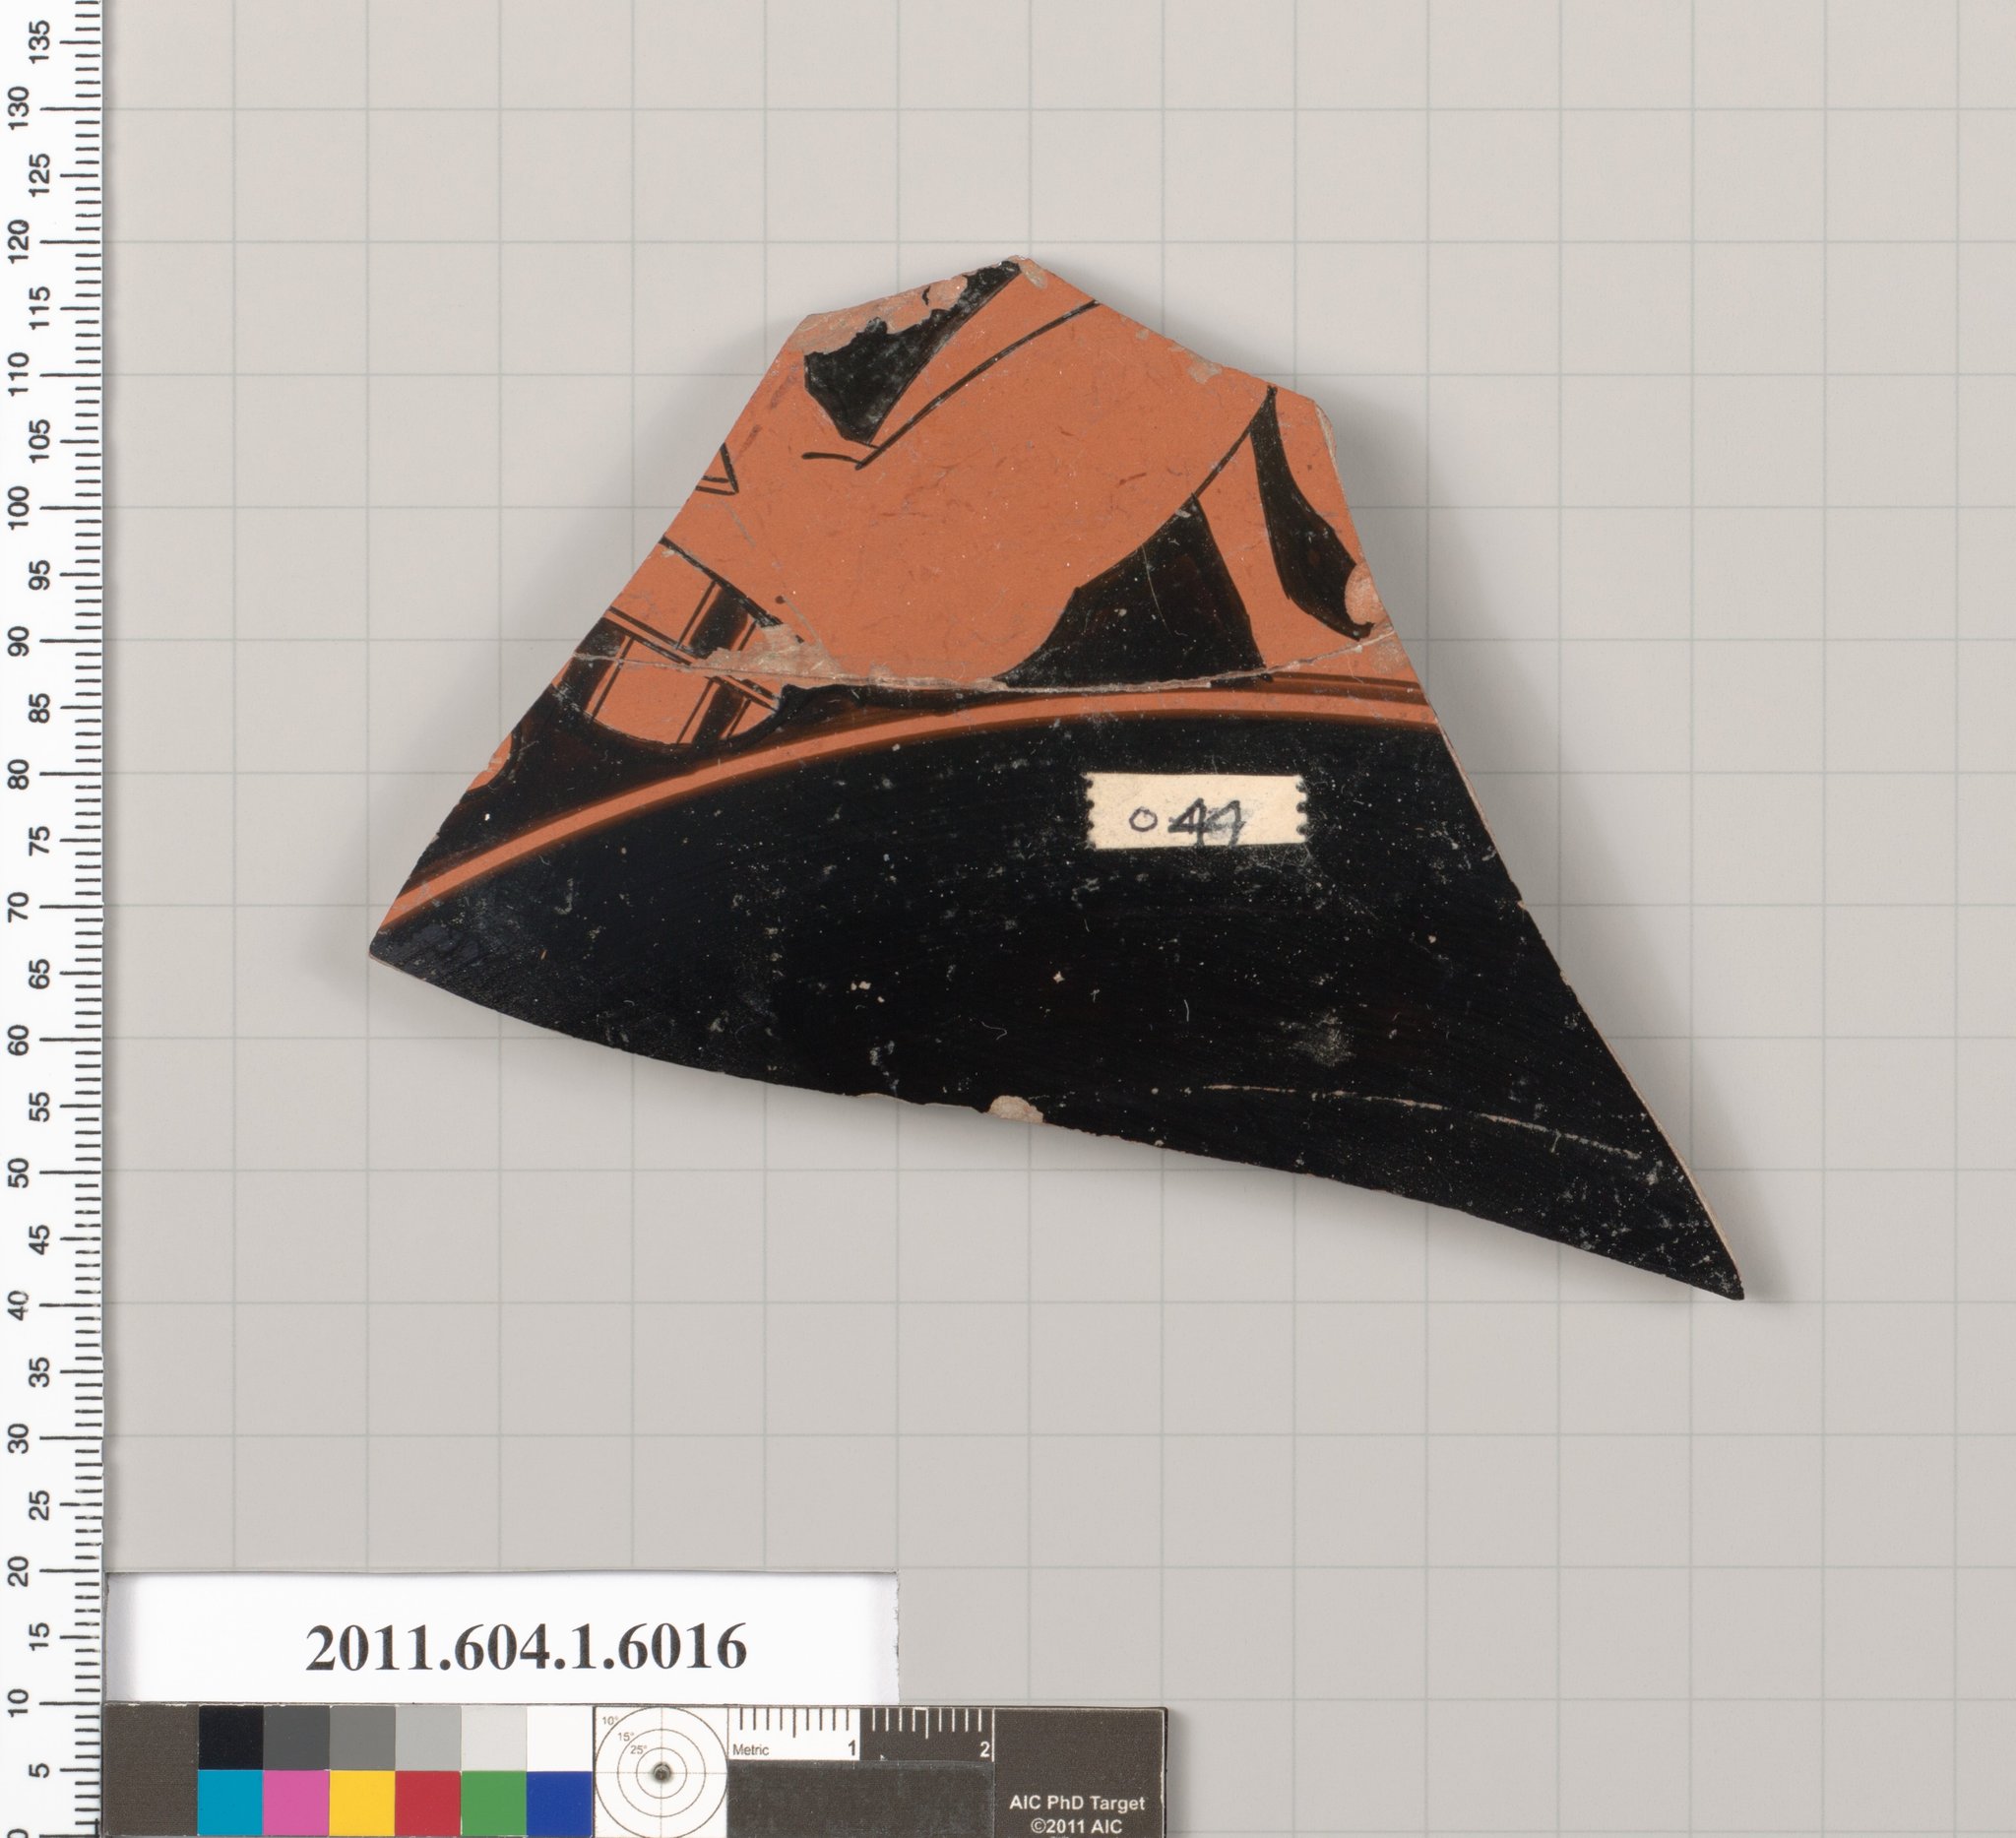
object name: kylix fragment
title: Terracotta fragment of a kylix (drinking cup)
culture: greek, attic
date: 510-500 BCE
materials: terracotta